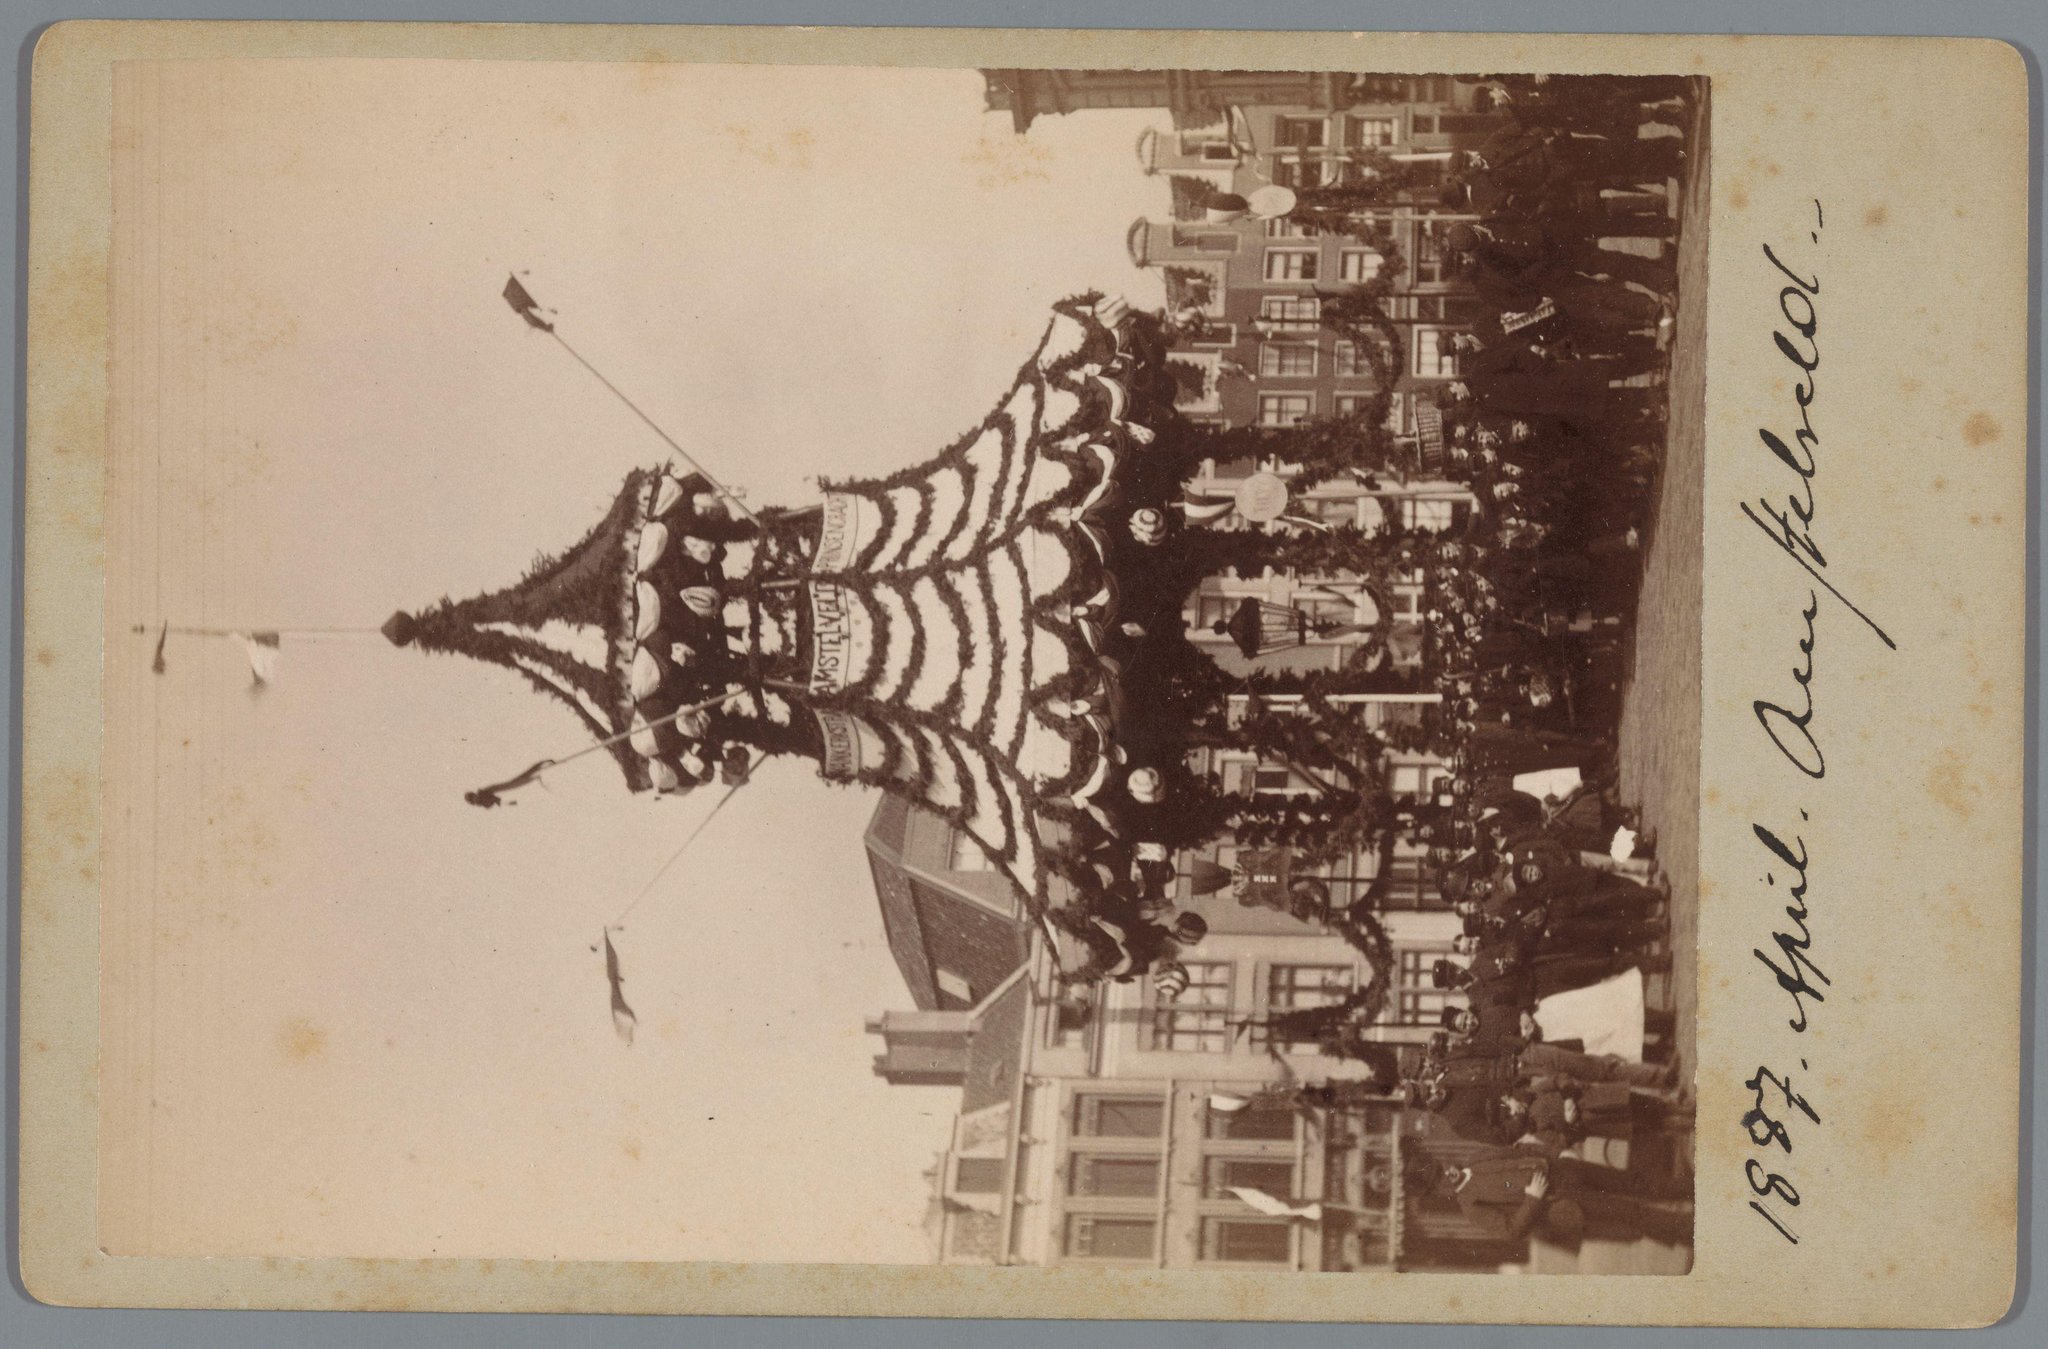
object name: photograph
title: Hoek Spiegelgracht/Weteringdwarsstraat / Lijnbaansgracht ("Als een wig in 't stadsbeeld")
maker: bernard eilers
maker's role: fotograaf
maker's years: 1878-1951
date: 1913-1940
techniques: rotogravure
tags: street